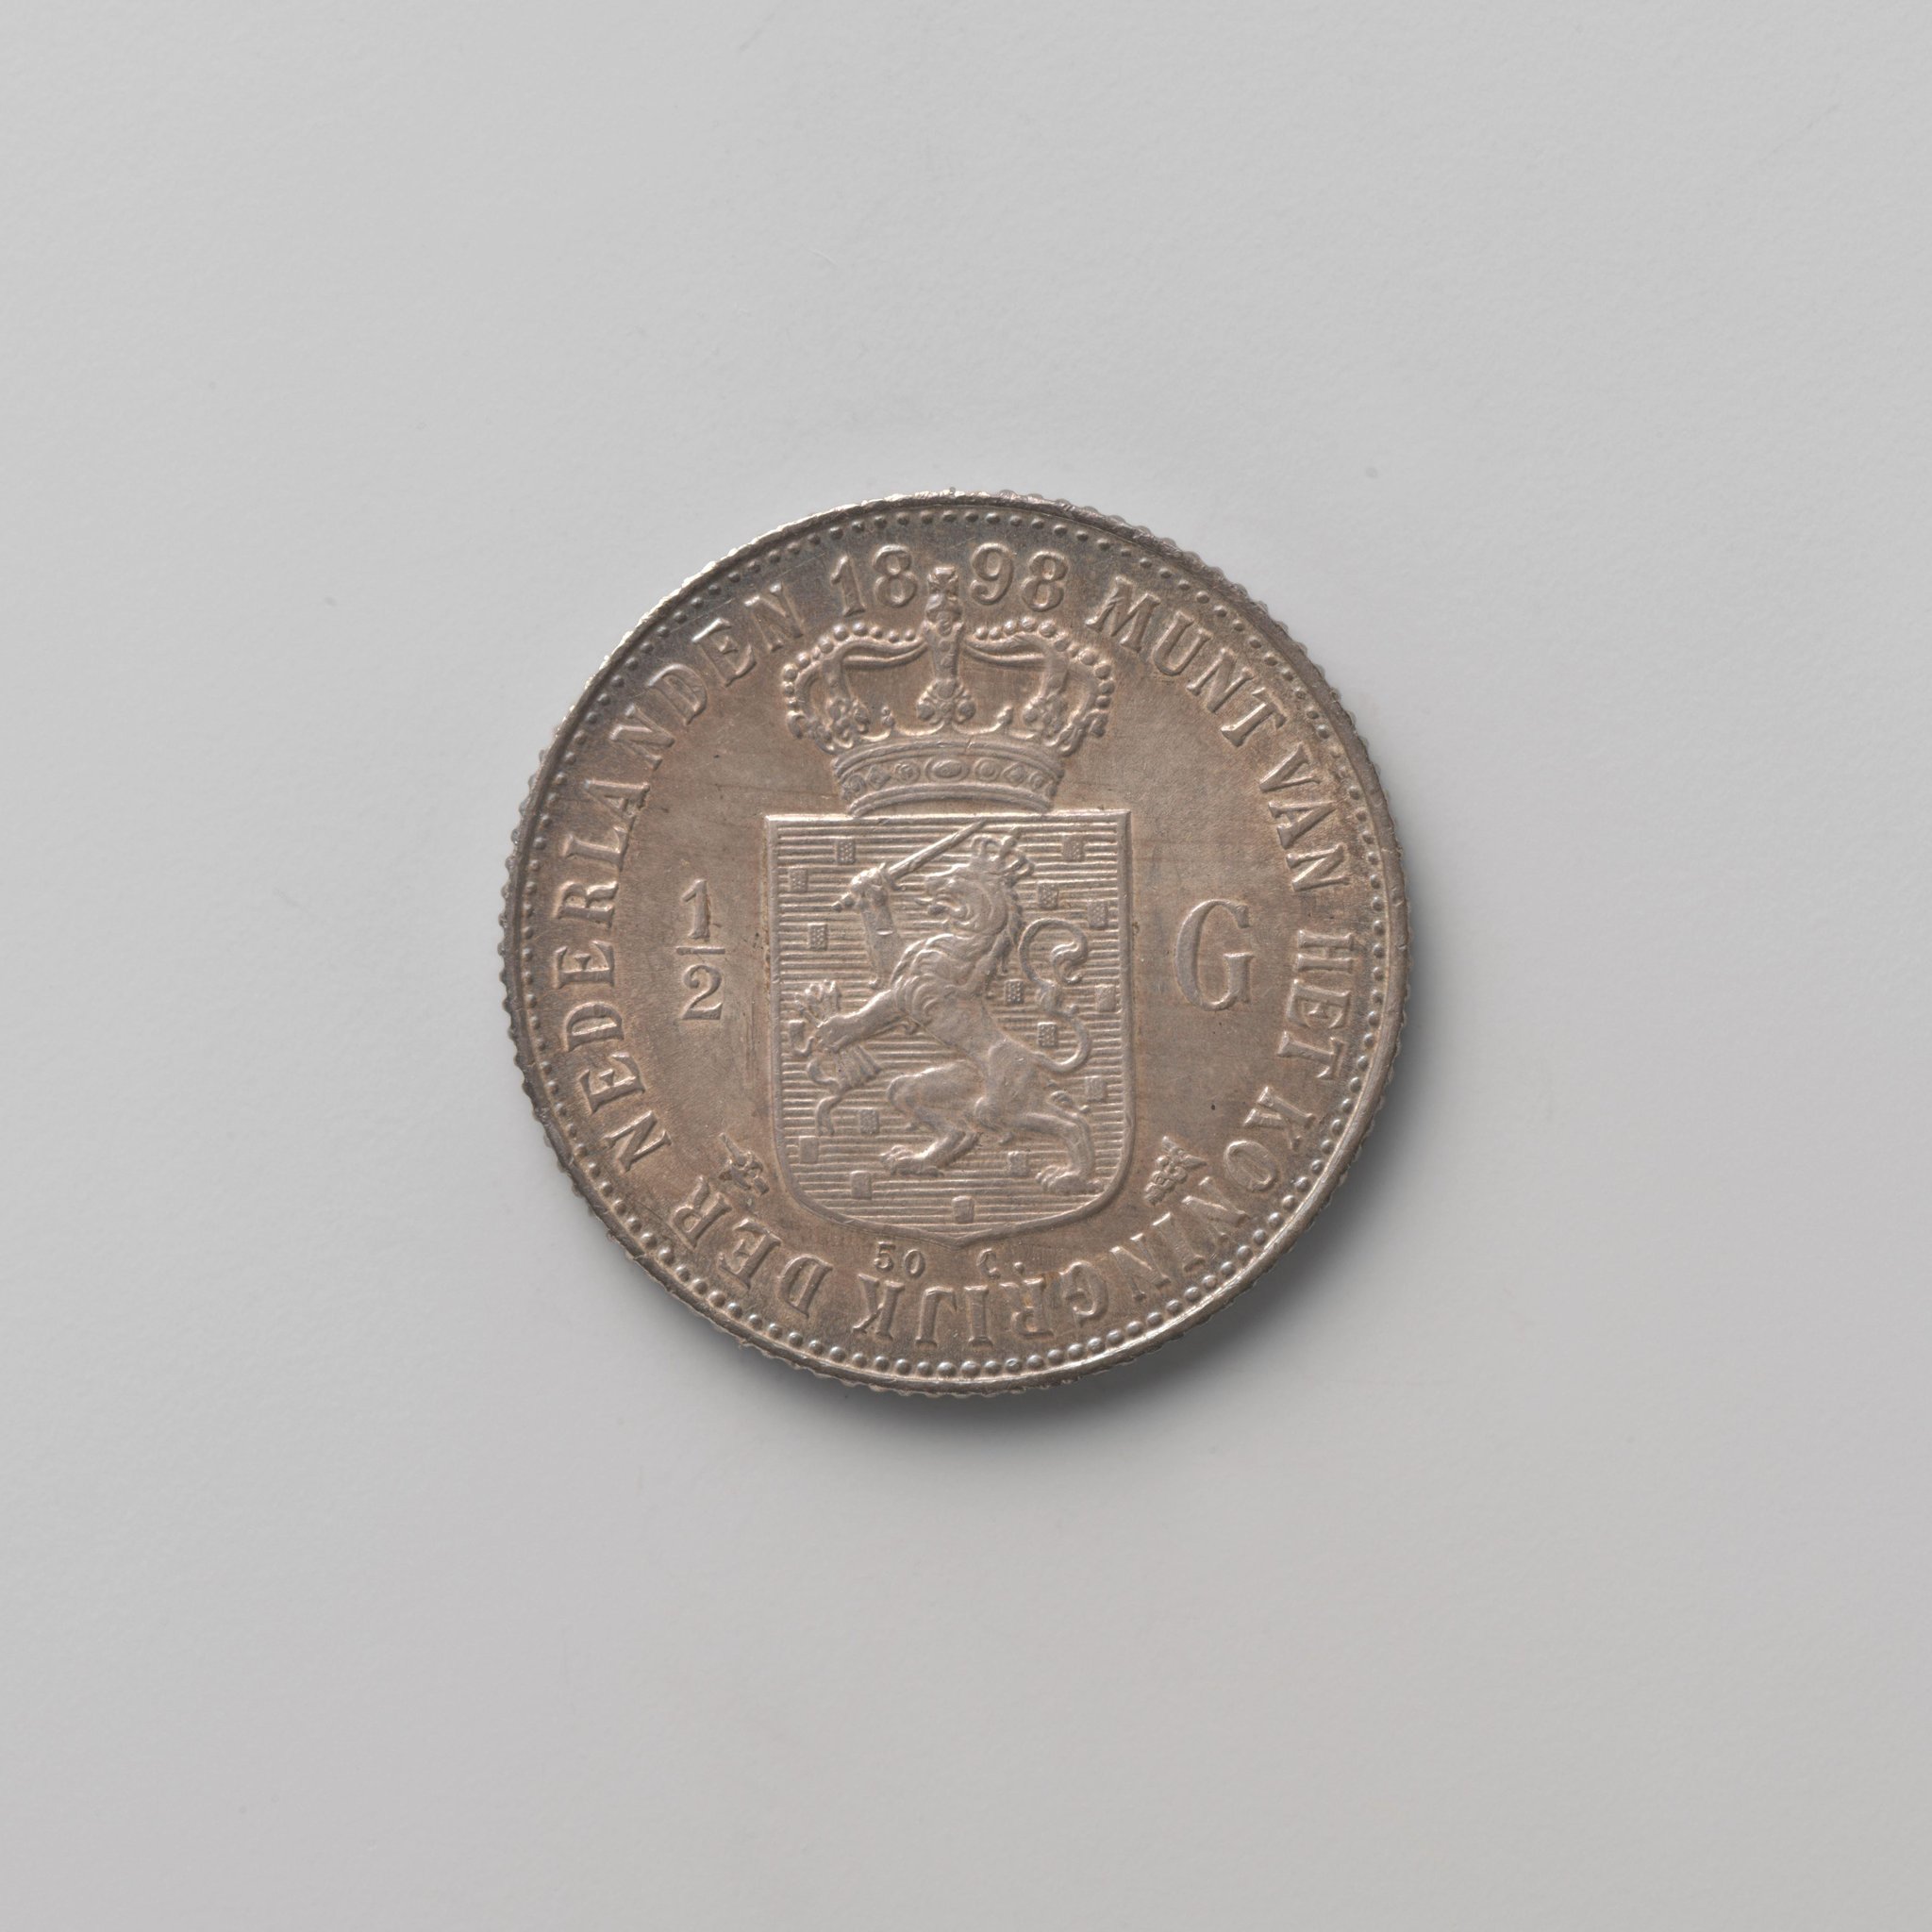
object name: coin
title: Nederland, ½ gulden,1898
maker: wilhelmina of the netherlands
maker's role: print maker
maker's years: 1880-1962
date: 1898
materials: silver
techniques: striking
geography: utrecht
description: Zilveren munt. Voorzijde: hoofd met diadeem naar links. Keerzijde: tussen waarde-aanduiding ½ G gekroond rijkswapenschild. Jaartal bovenaan in omschrift. Kartelrand.